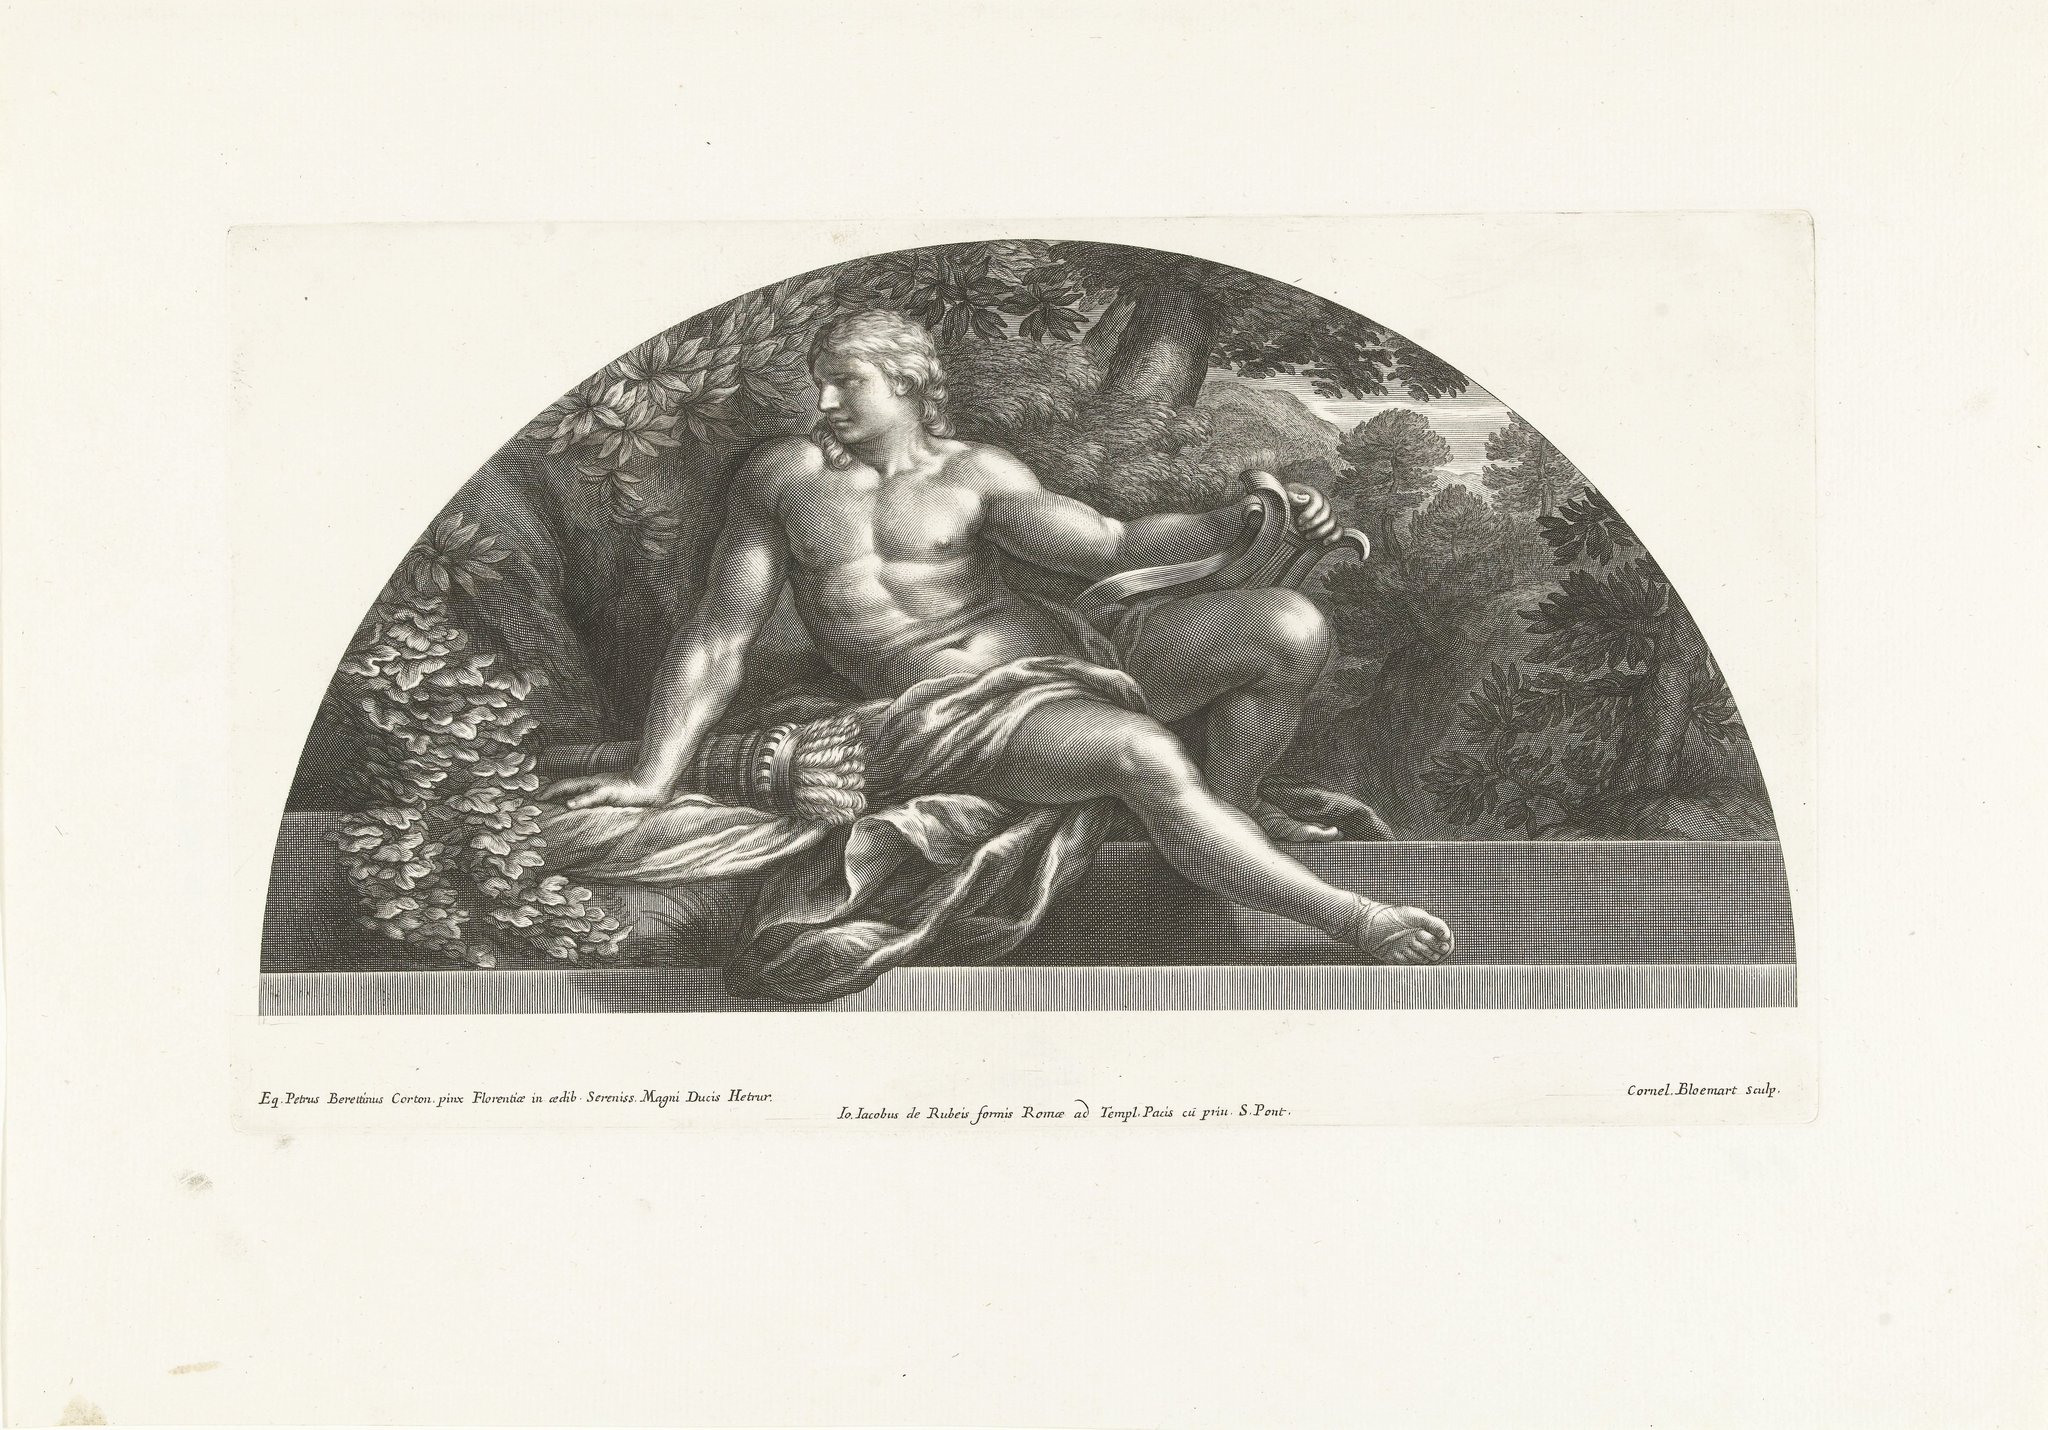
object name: print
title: Apollo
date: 1637-1692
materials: paper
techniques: engraving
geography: rome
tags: (story of) apollo (phoebus)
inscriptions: collector's mark: Lugt 2228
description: Apollo zit op een stenen trap in de natuur. Als god van de boogschutters draagt hij een pijlkoker, de lier bezit hij als beschermgod van de poëzie en de muziek, en als aanvoerder van de Muzen. Prent uit een serie van vier prenten naar fresco's van Pietro da Cortona.